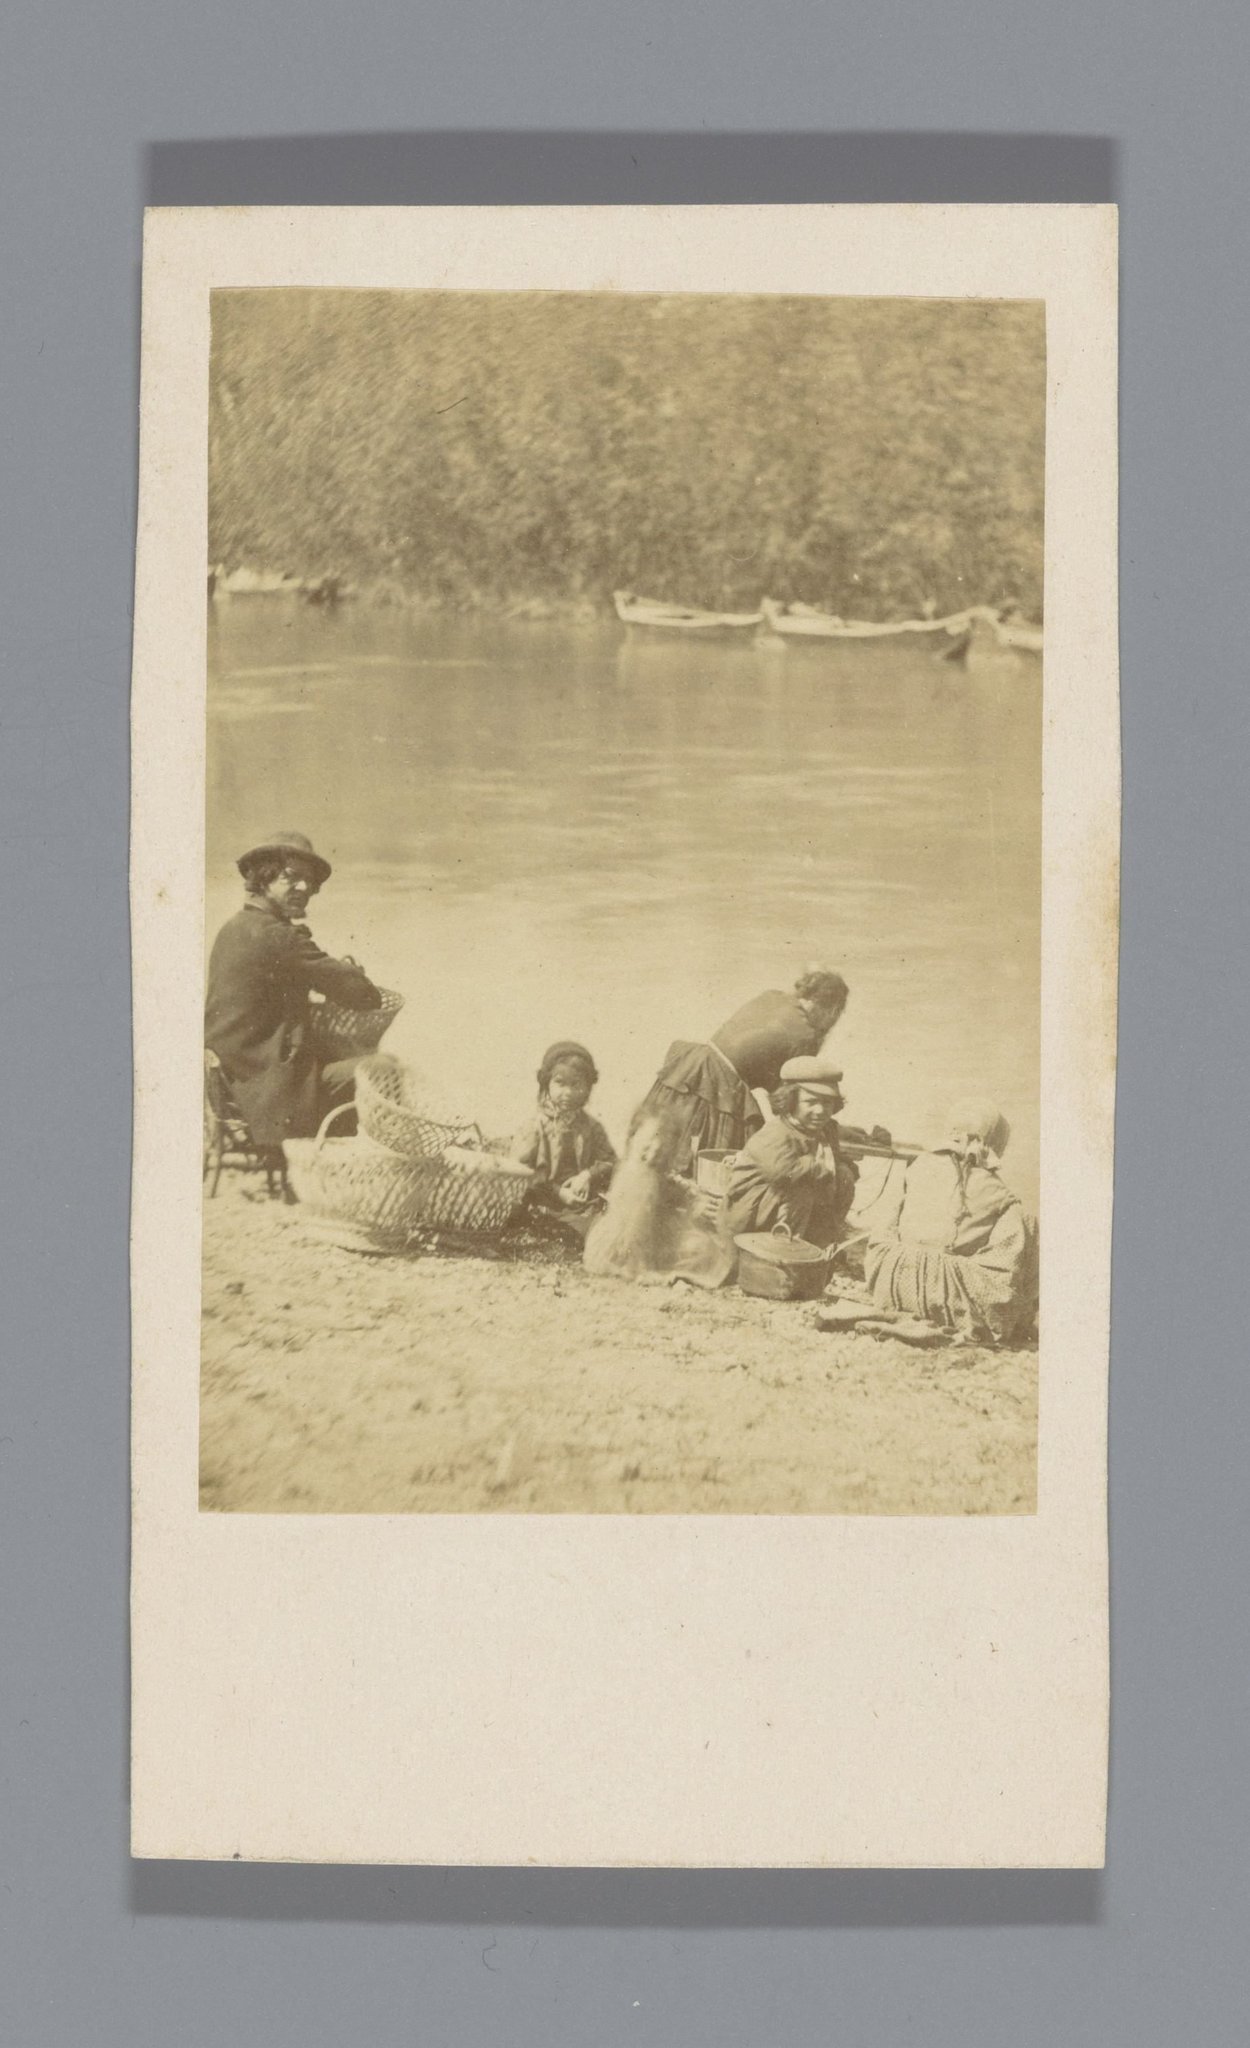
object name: carte de visite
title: Gezelschap aan rivieroever, waarschijnlijk aan de Seine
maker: Anonymous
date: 1865-1870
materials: cardboard, paper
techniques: albumen print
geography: france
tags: midday meal, lunch - cc - out of doors, river bank, france